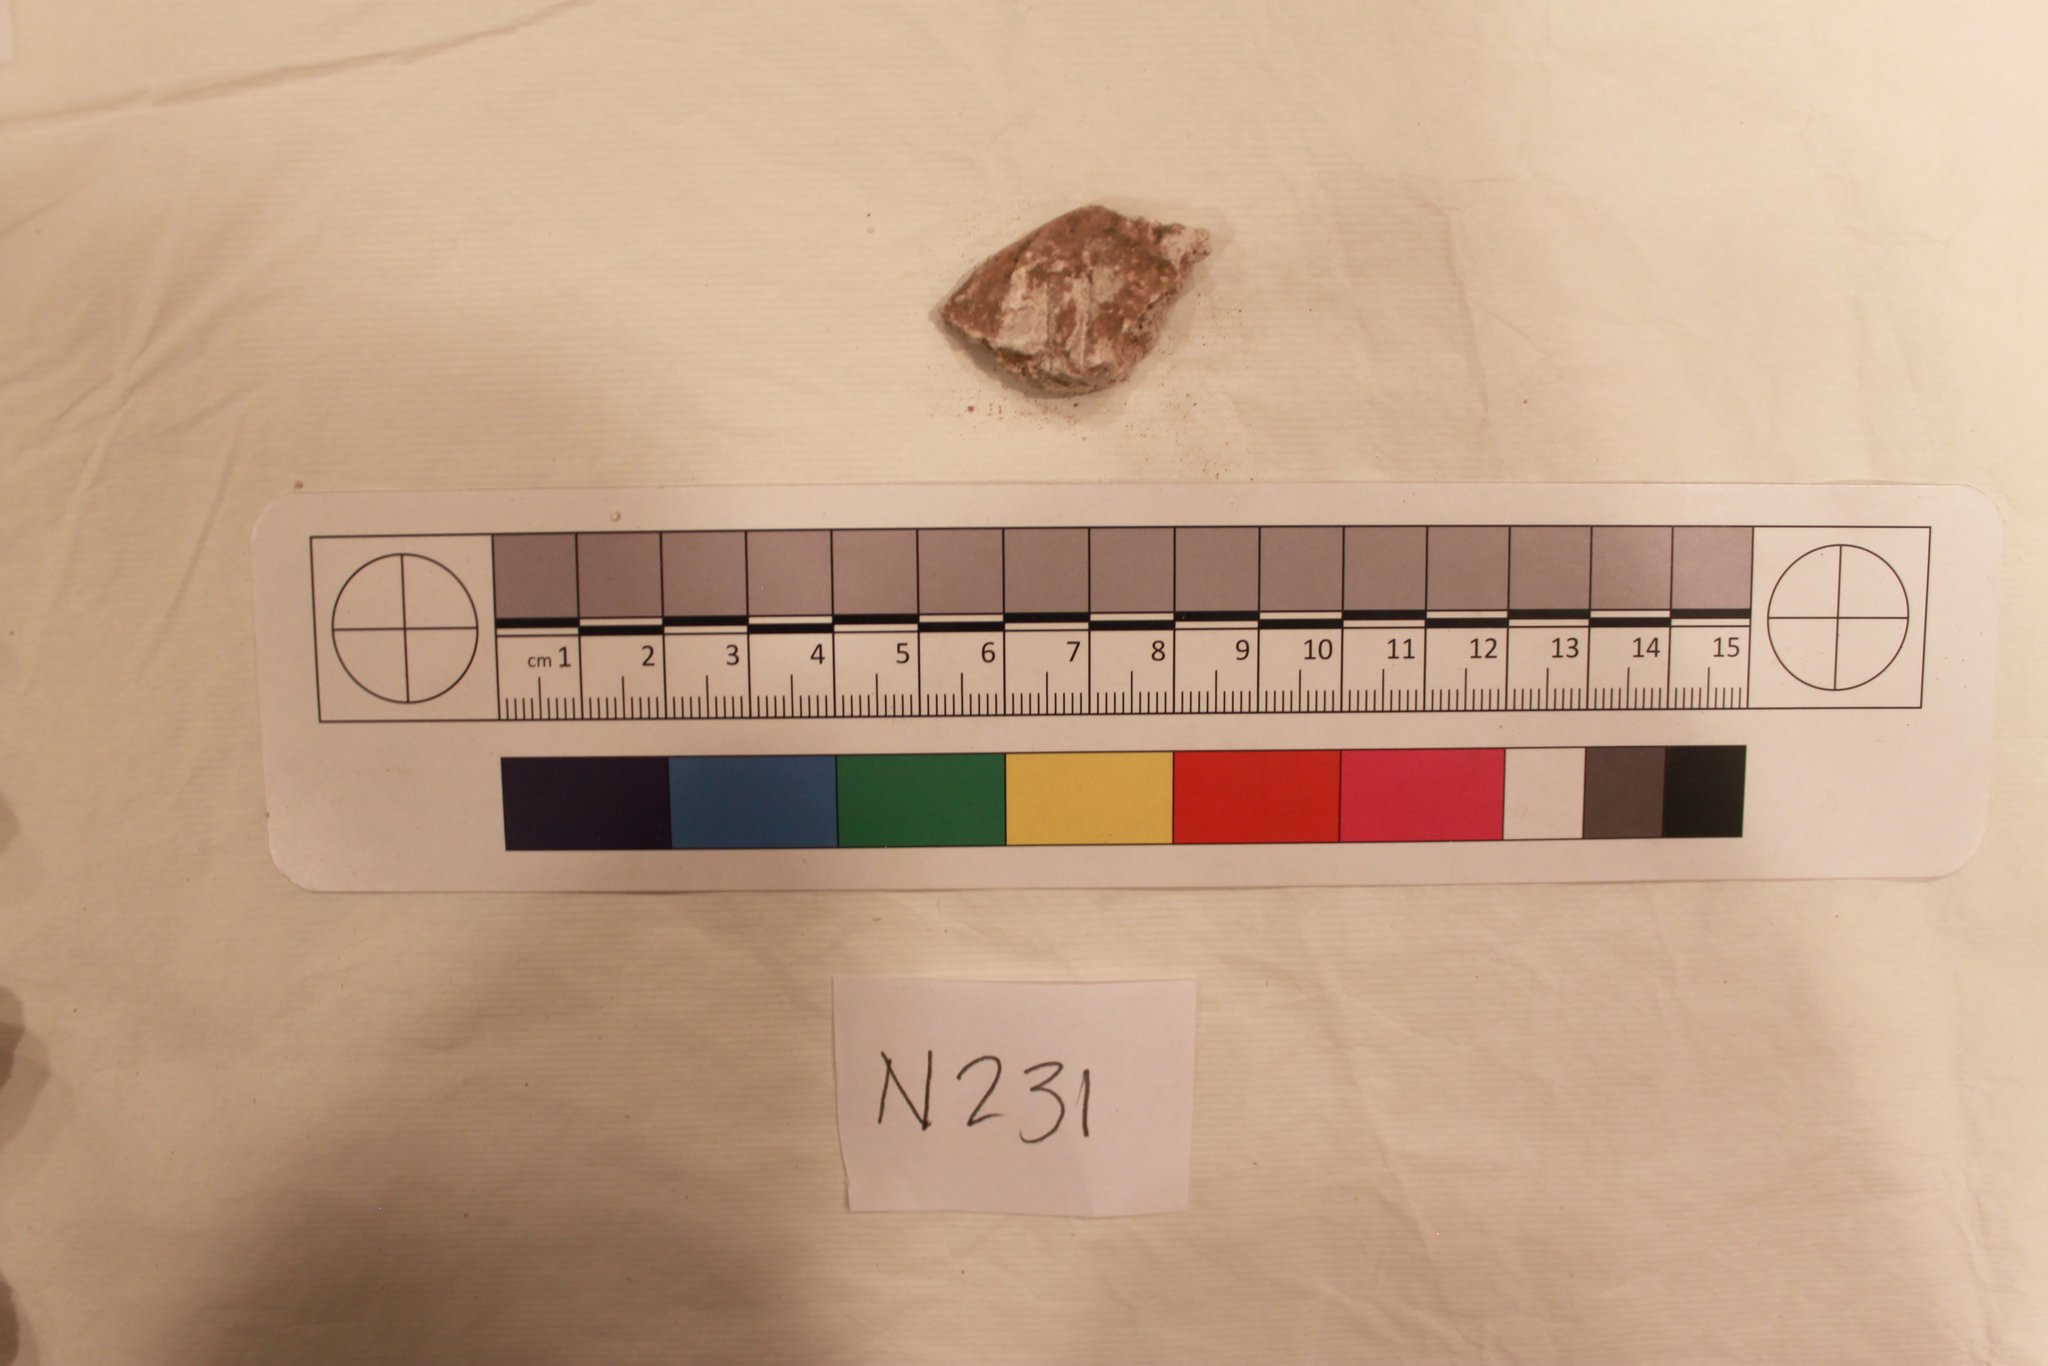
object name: fragment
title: Stucco Fragment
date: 701-1200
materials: plaster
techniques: carving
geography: iran